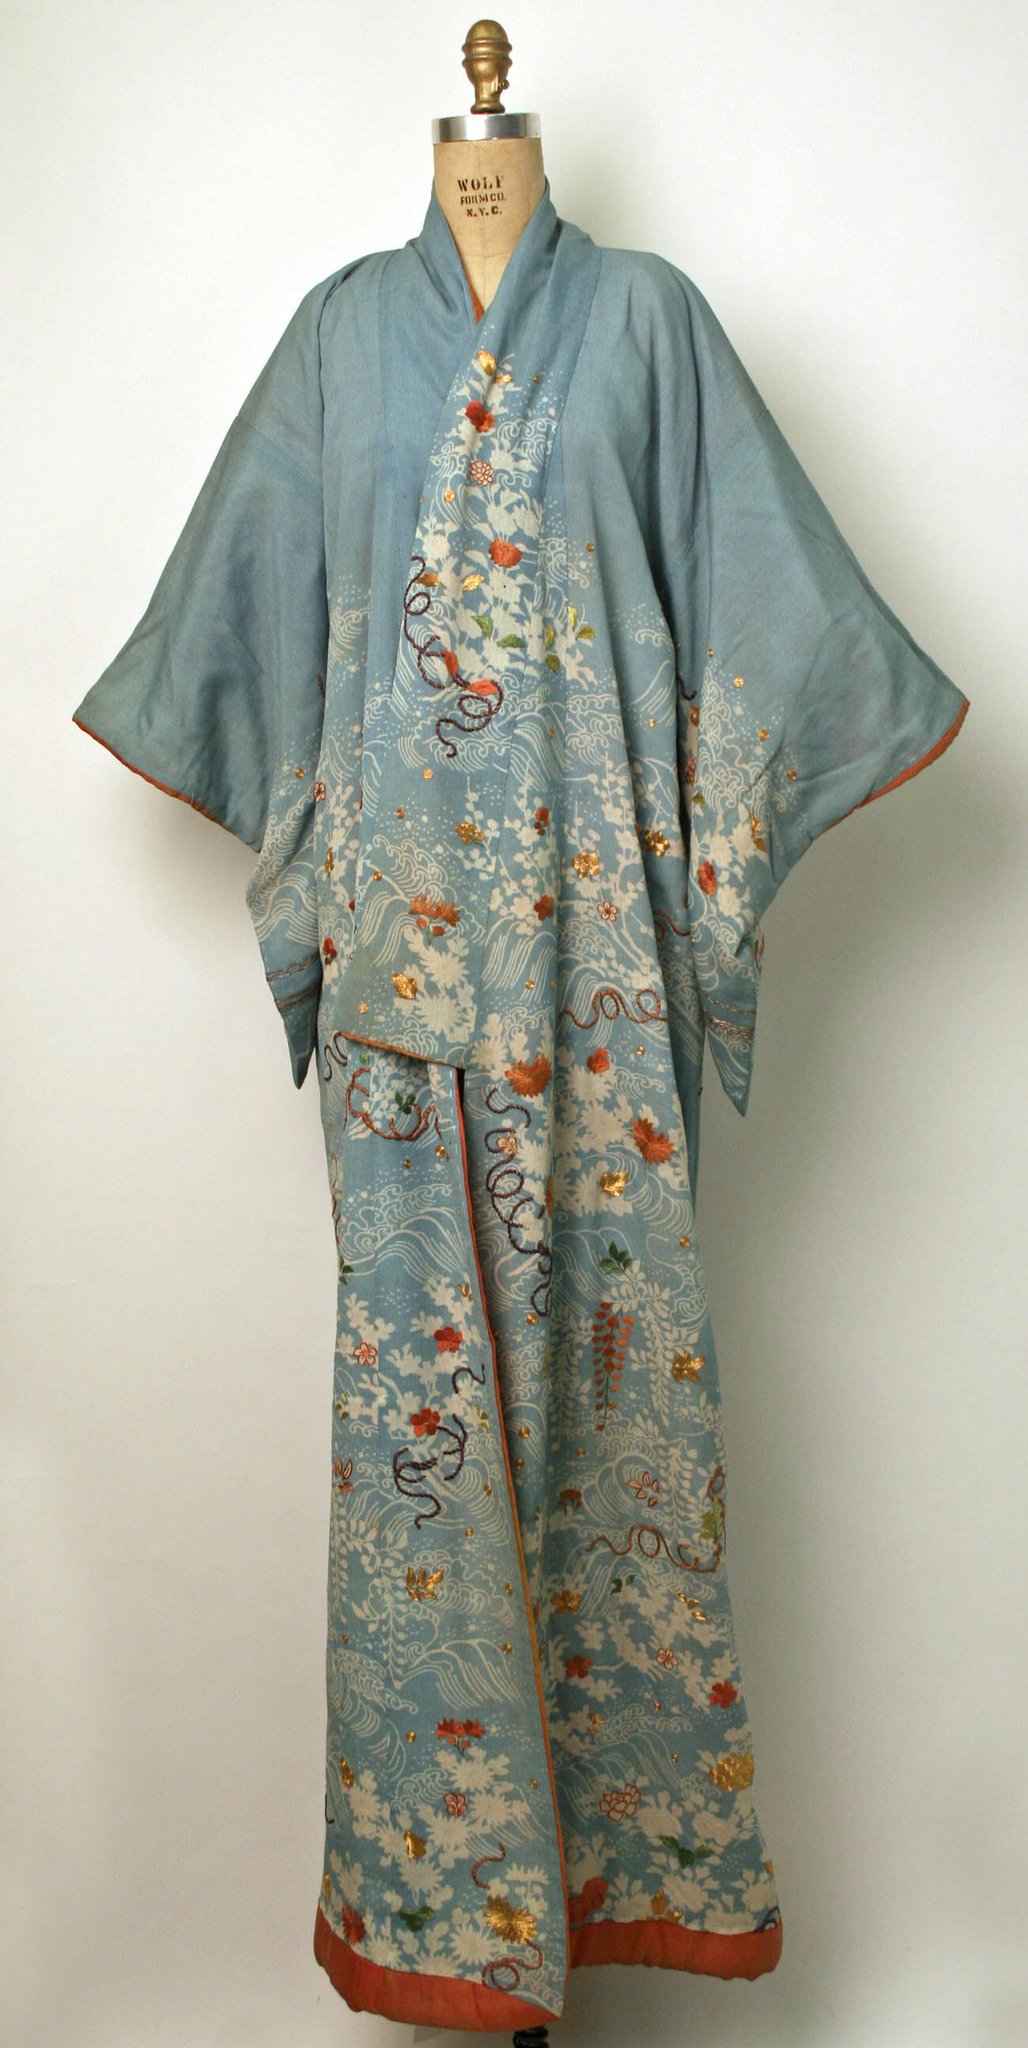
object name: kimono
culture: japanese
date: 1801-1900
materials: silk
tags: flowers